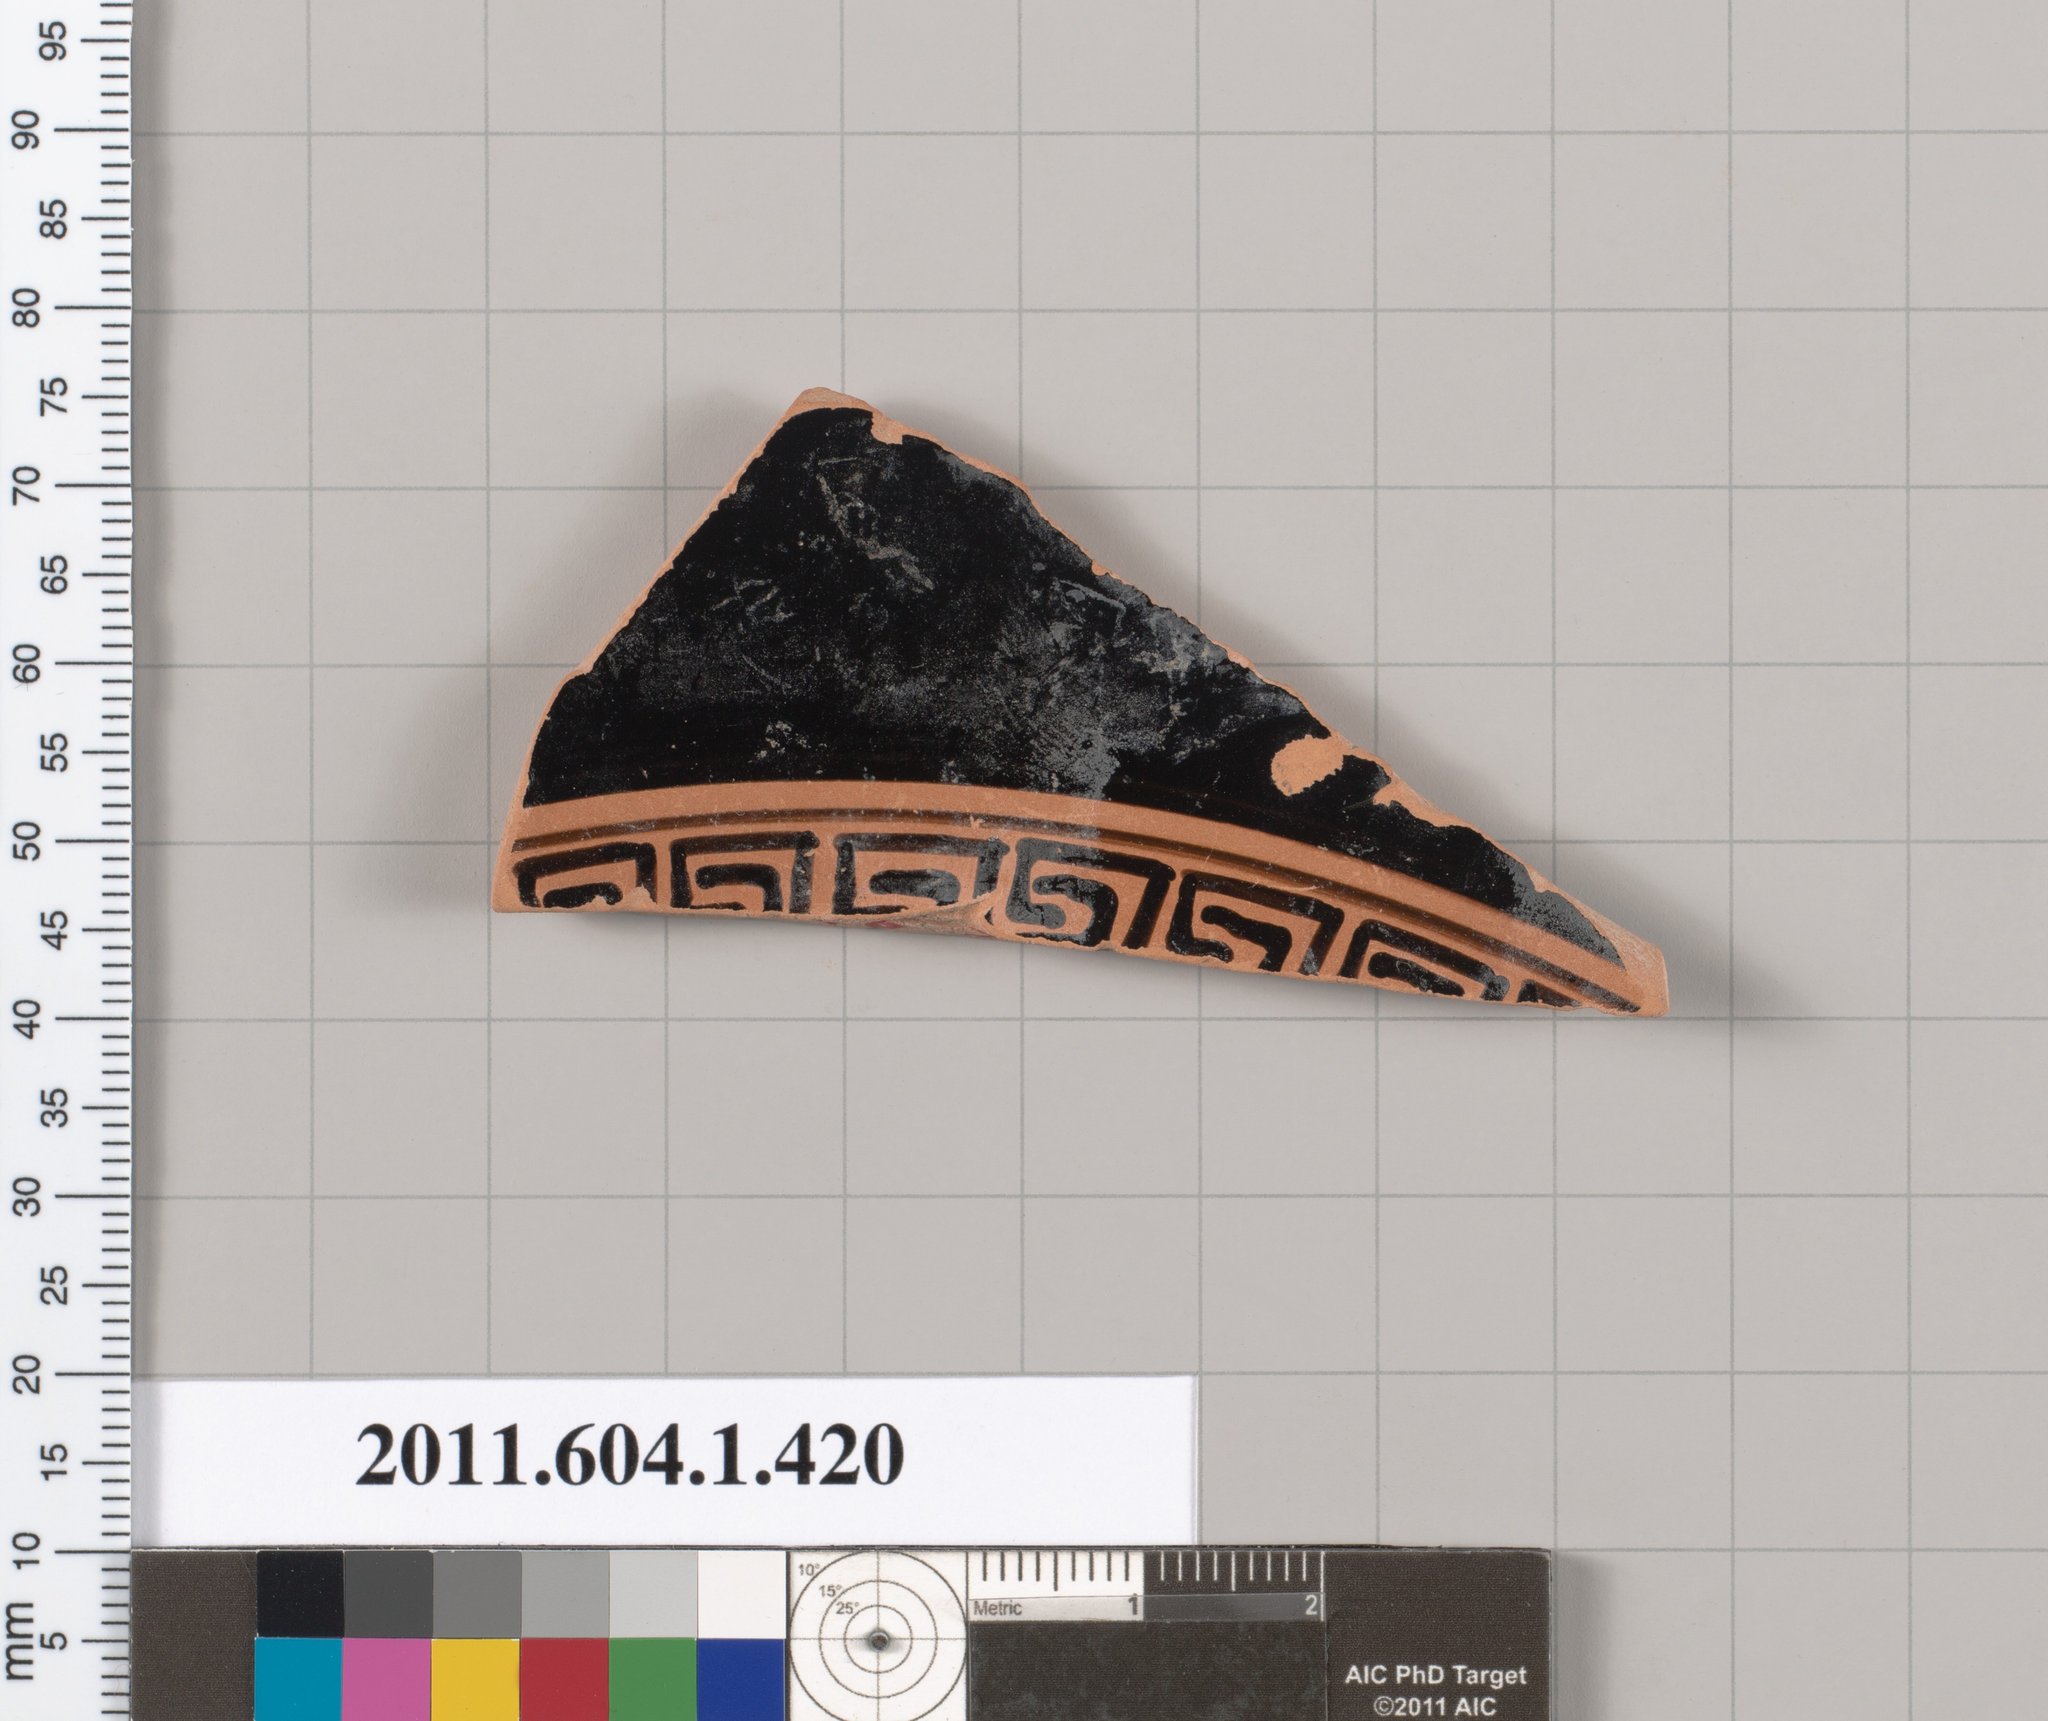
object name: kylix fragment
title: Terracotta fragment of a kylix (drinking cup)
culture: greek, attic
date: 475-451 BCE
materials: terracotta